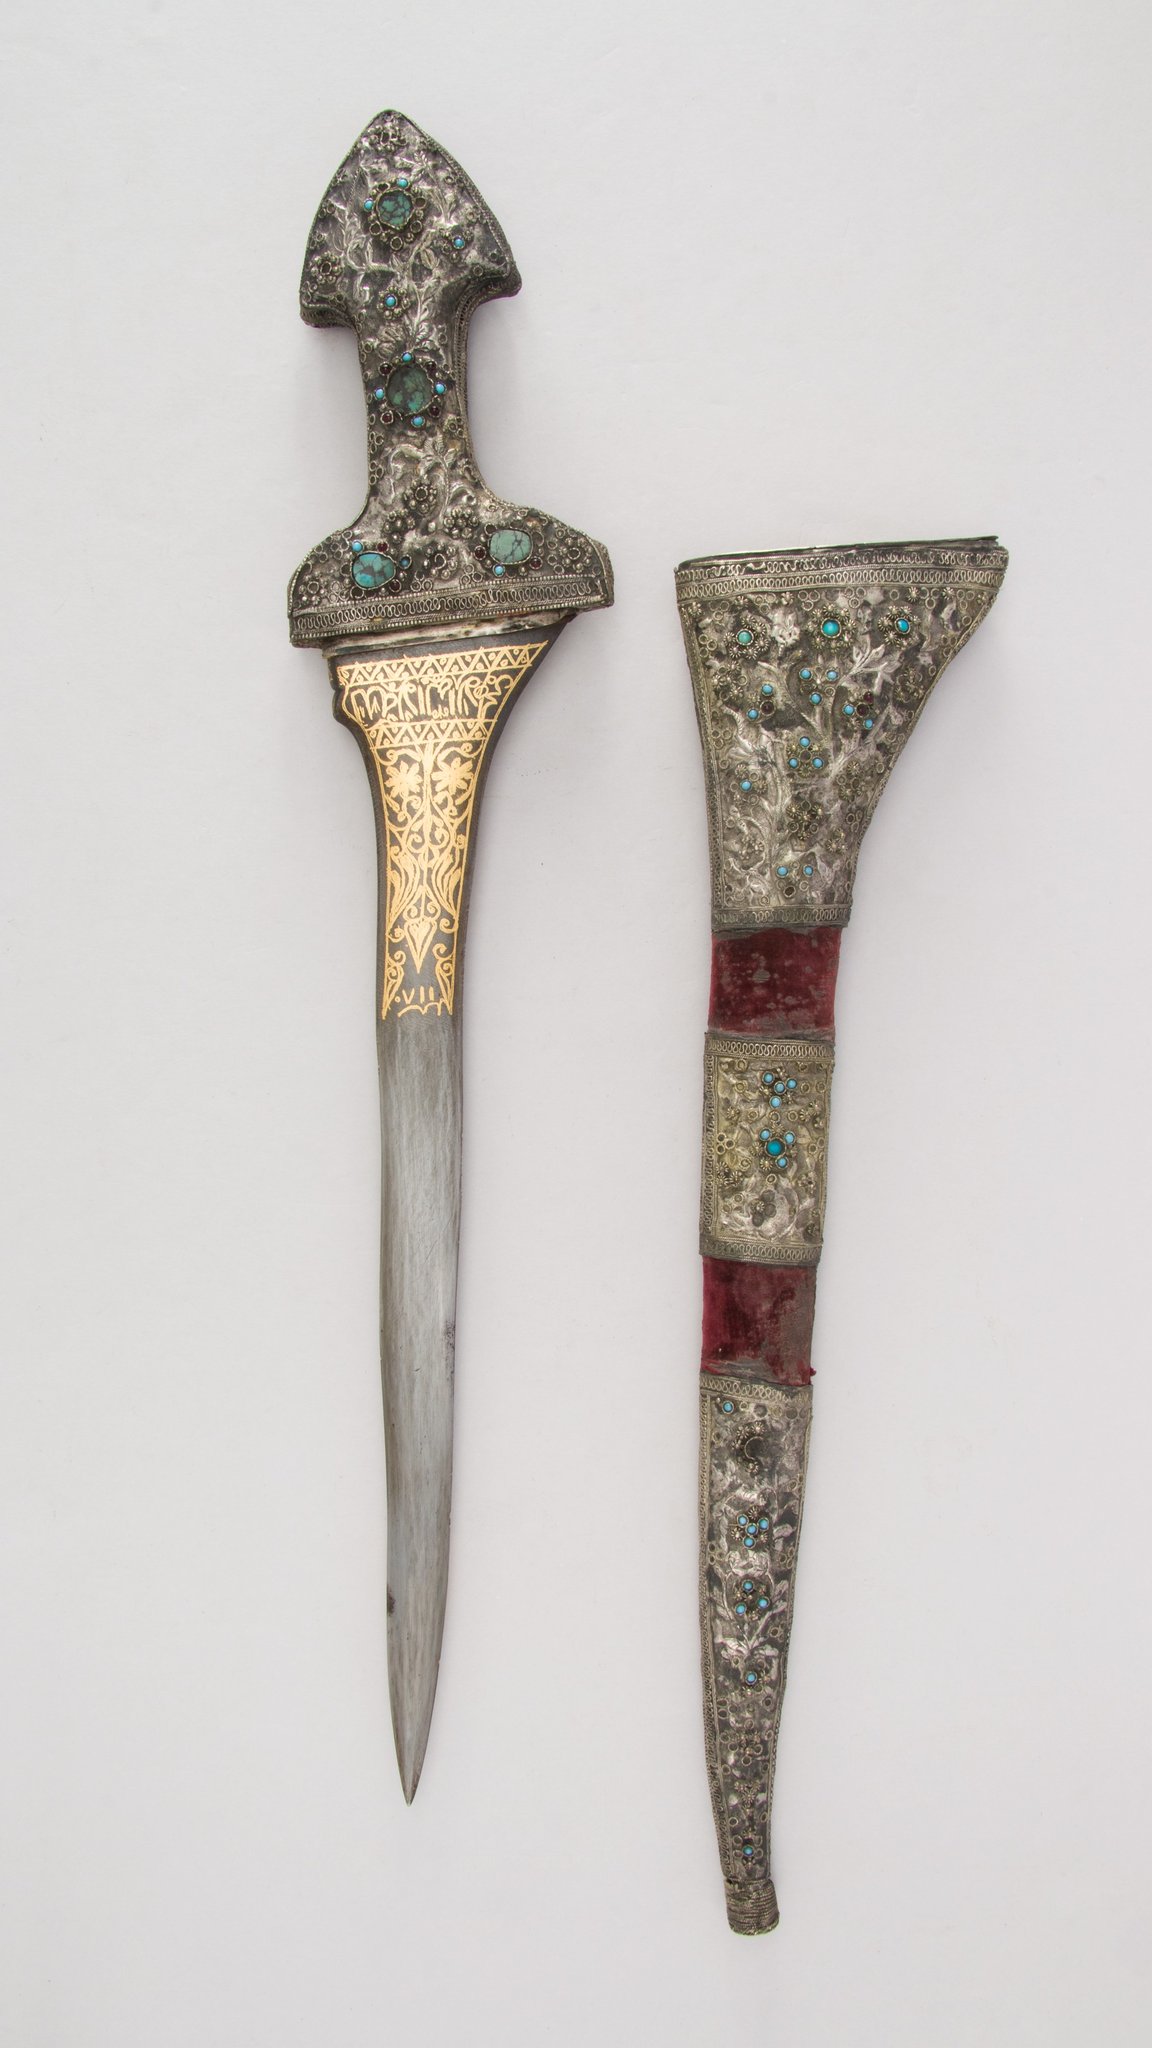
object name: kris with sheath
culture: malayan or turkish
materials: gemstone, silver, steel, wood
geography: ottoman empire